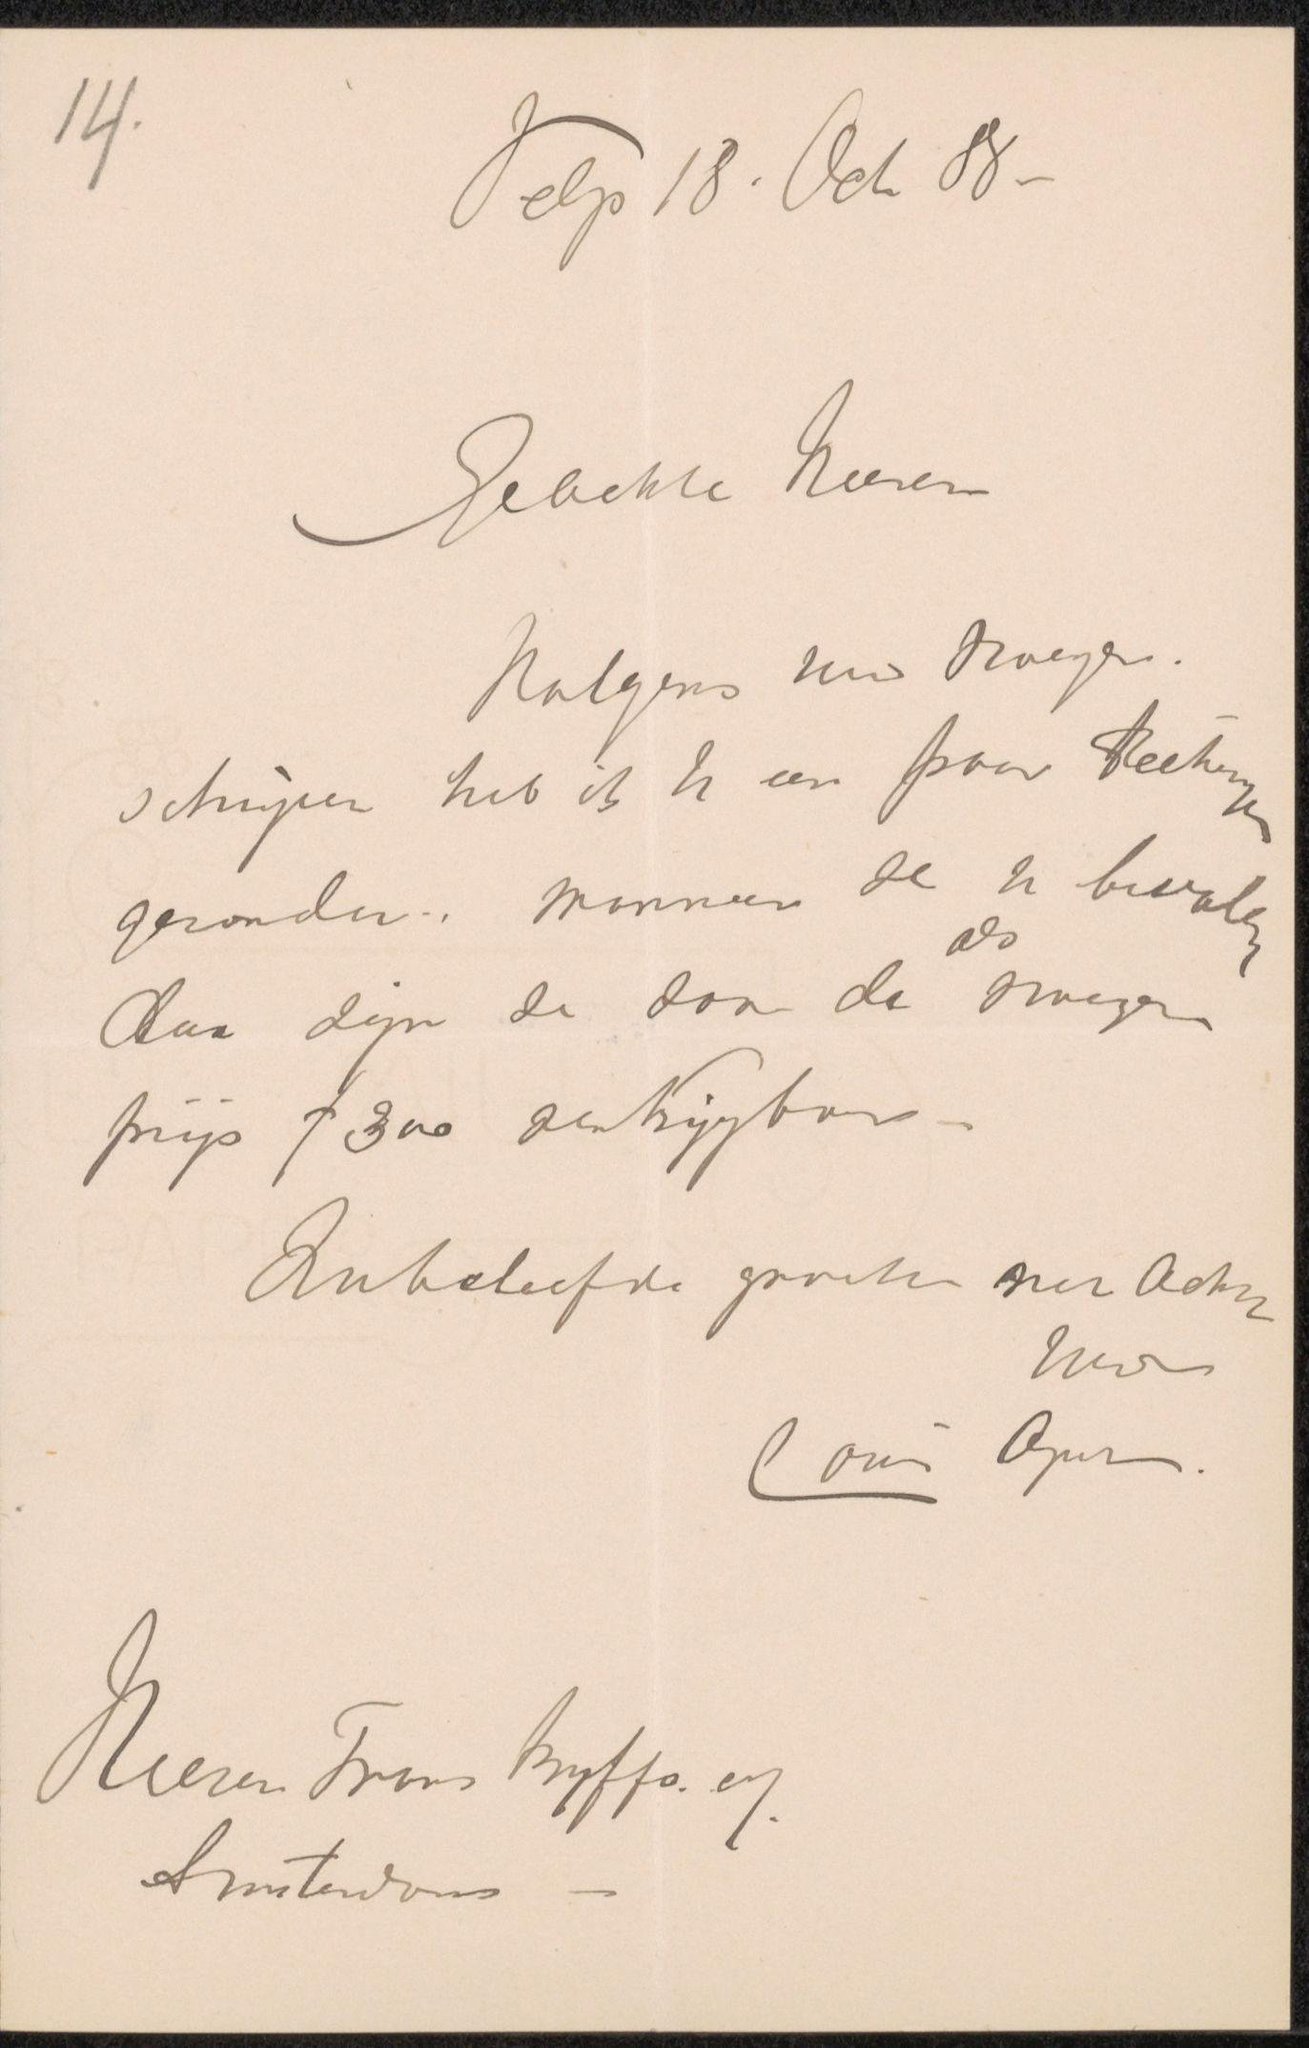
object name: letter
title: Brief aan Frans Buffa en Zonen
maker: louis apol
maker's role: draughtsman, painter, print maker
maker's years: 1850-1936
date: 1888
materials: ink, paper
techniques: pen, writing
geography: velp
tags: drawing, money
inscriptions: collector's mark: Lugt 2233